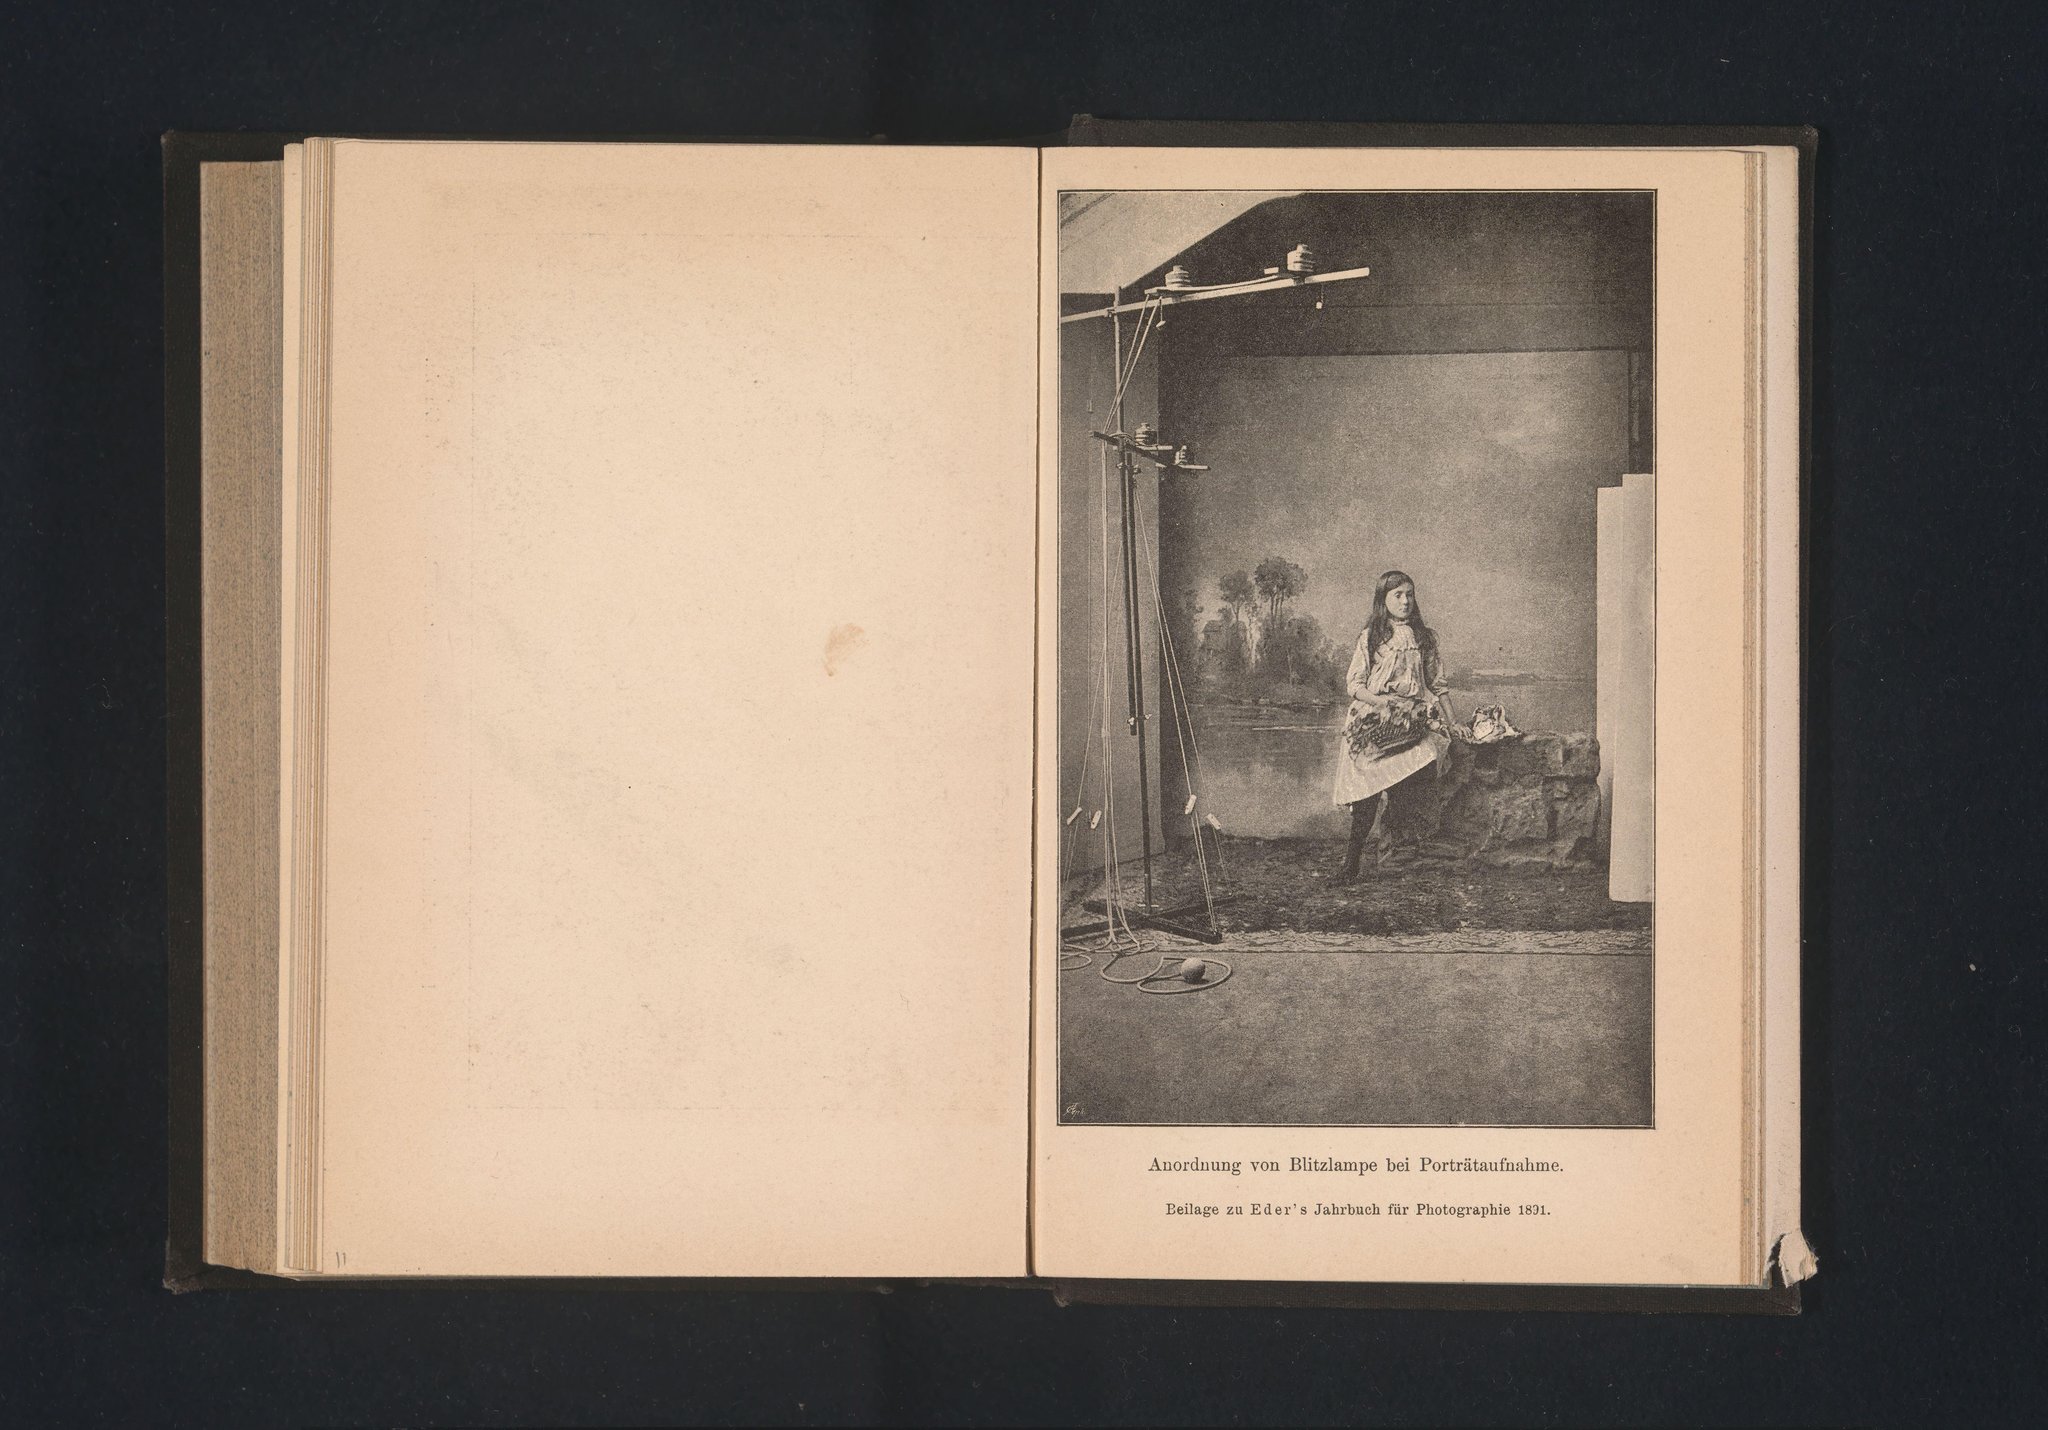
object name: photomechanical print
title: Studioportret van een onbekend meisje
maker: Anonymous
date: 1886-1891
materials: paper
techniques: autotype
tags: studio ~ photographer, historical persons - bb - woman, girl (child between toddler and youth)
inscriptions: inscription: ‘Anordnung von Blitzlampe bei Porträtaufnahme/ Beilage zu Eder's Jahbruch für Photographie 1891’, monogram: ‘AC’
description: Prent op tweeëndertigste ongenummerde pagina na pagina 627.